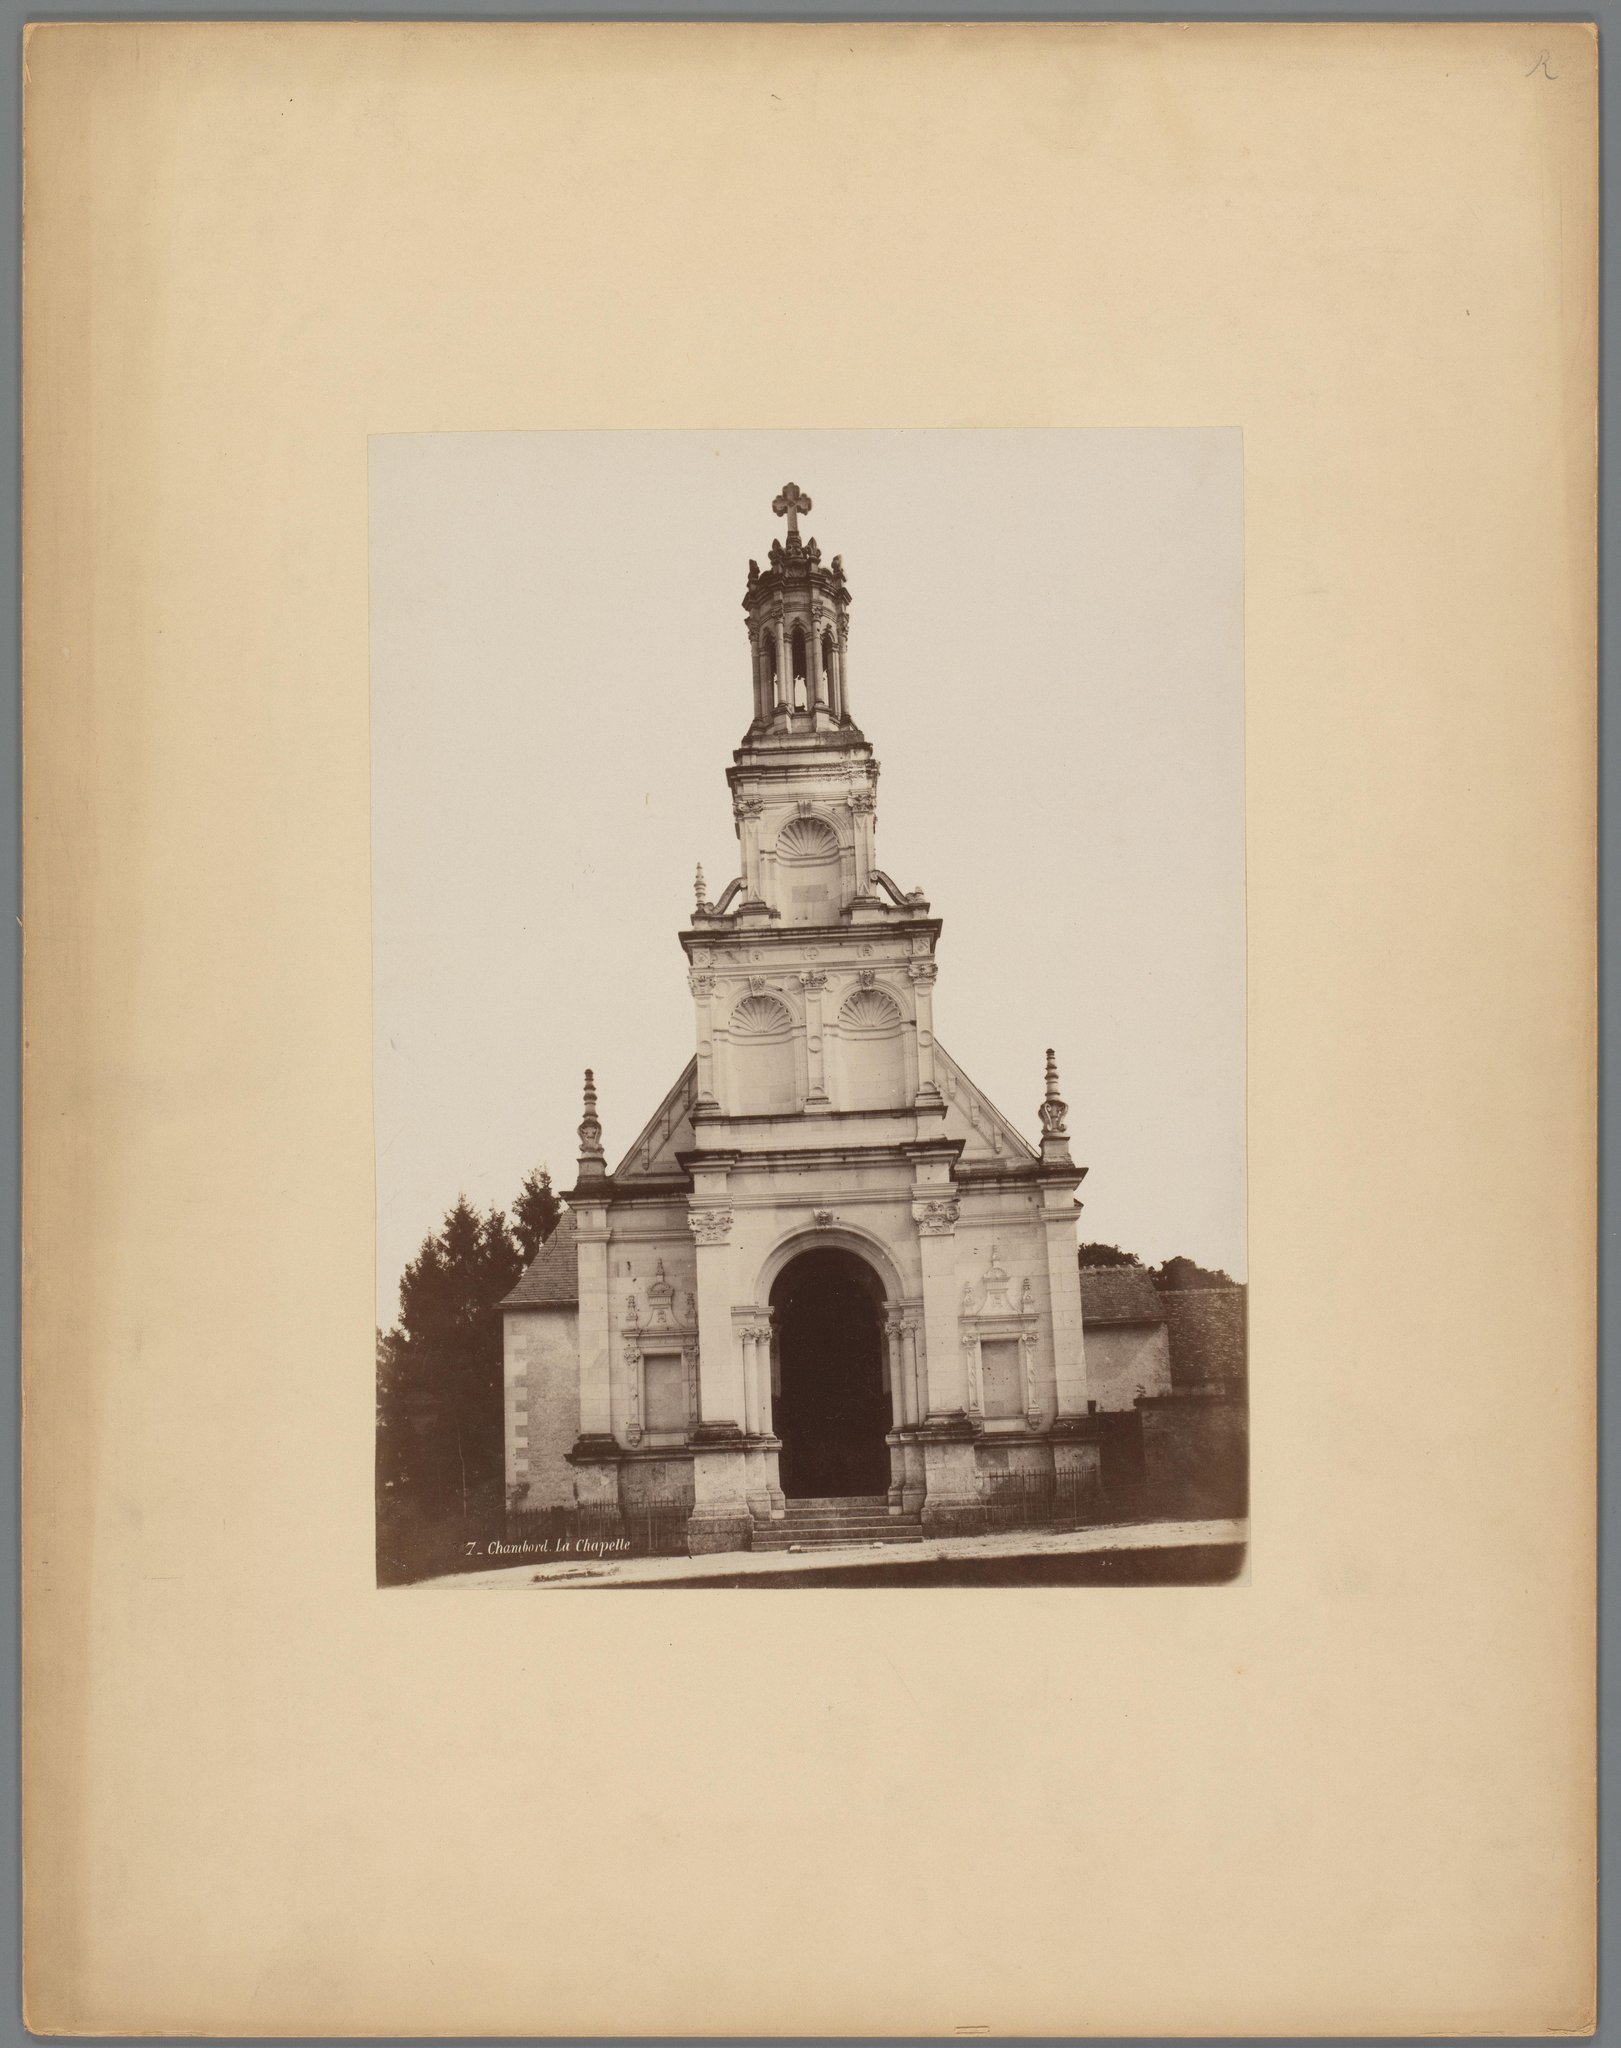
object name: photograph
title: Façade van de Église Saint-Louis in Chambord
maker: Anonymous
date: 1860-1890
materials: cardboard, paper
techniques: albumen print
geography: chambord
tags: parts of church exterior and annexes: façade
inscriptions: collector's mark: Lugt 3937, number: ‘7.’